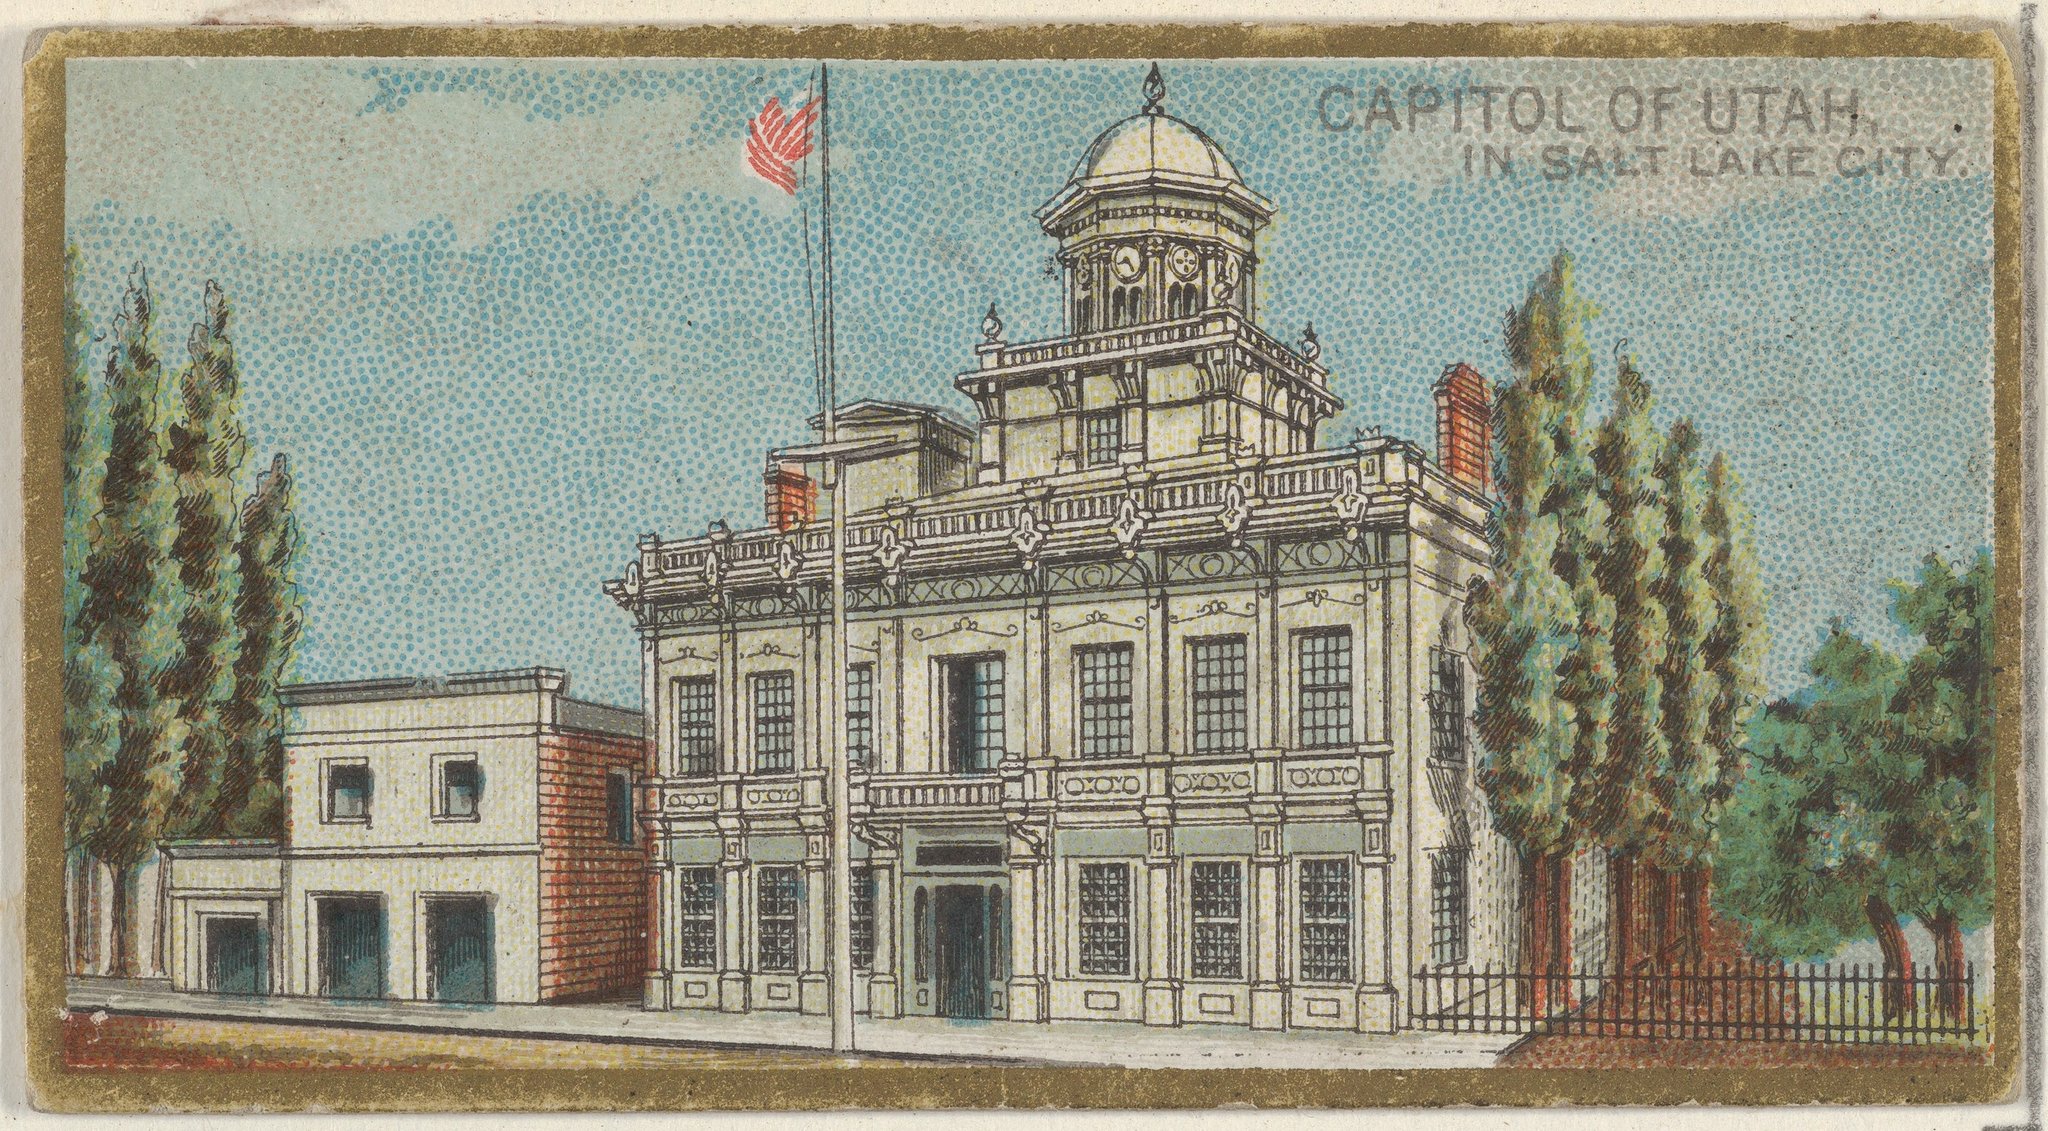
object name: print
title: Capitol of Utah in Salt Lake City, from the General Government and State Capitol Buildings series (N14) for Allen & Ginter Cigarettes Brands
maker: allen & ginter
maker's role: publisher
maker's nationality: american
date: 1889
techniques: color lithograph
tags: buildings